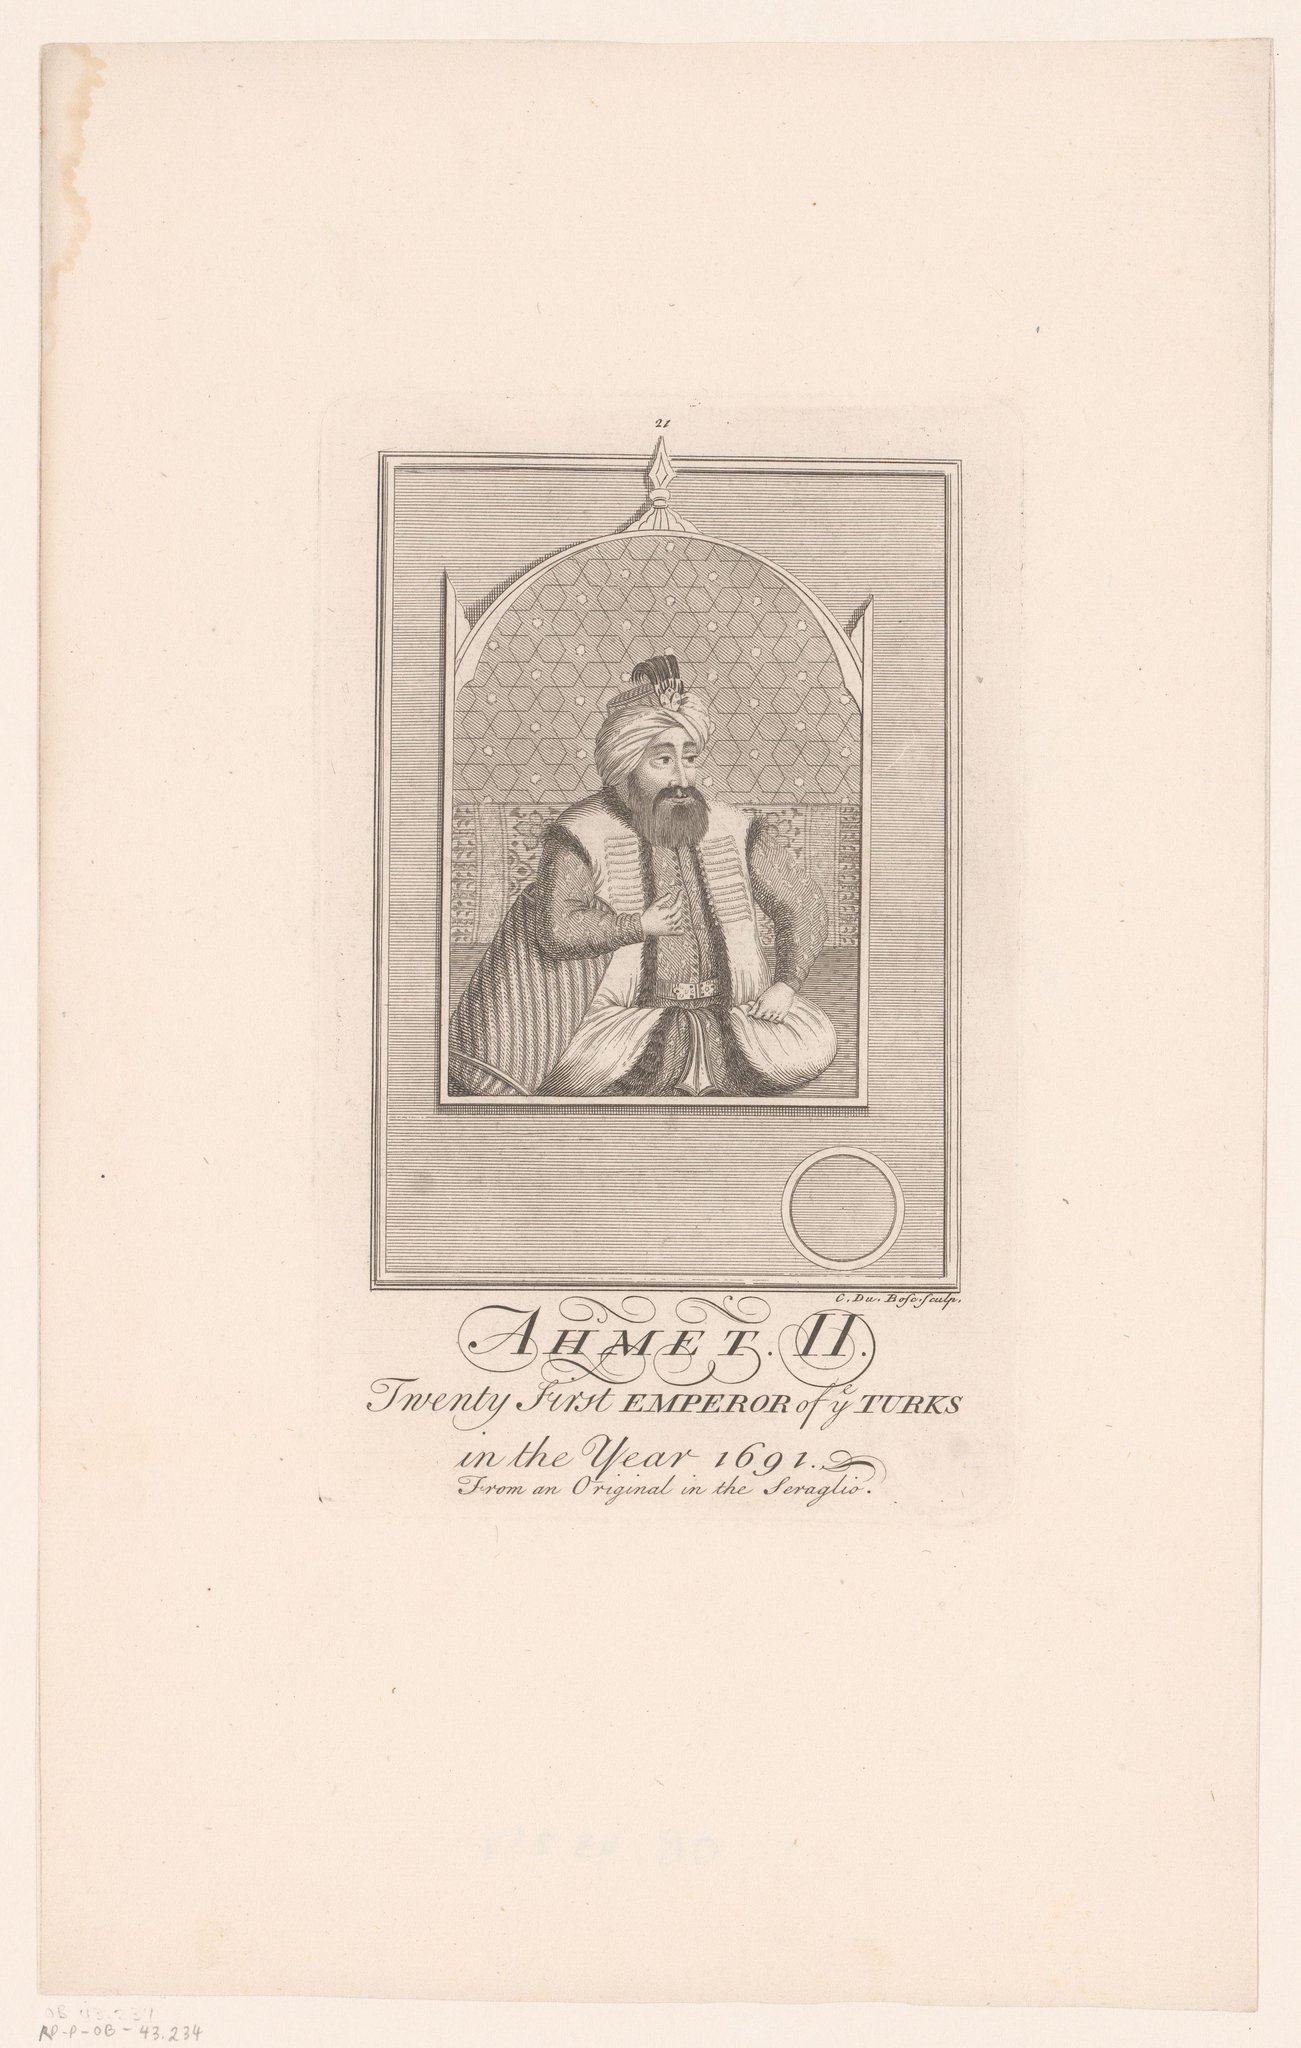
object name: print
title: Ahmet. II.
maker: claude dubosc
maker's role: print maker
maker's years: 1682-1745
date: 1692-1745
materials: paper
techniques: engraving, etching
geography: france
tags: historical persons, ruler, sovereign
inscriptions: collector's mark: Lugt 240